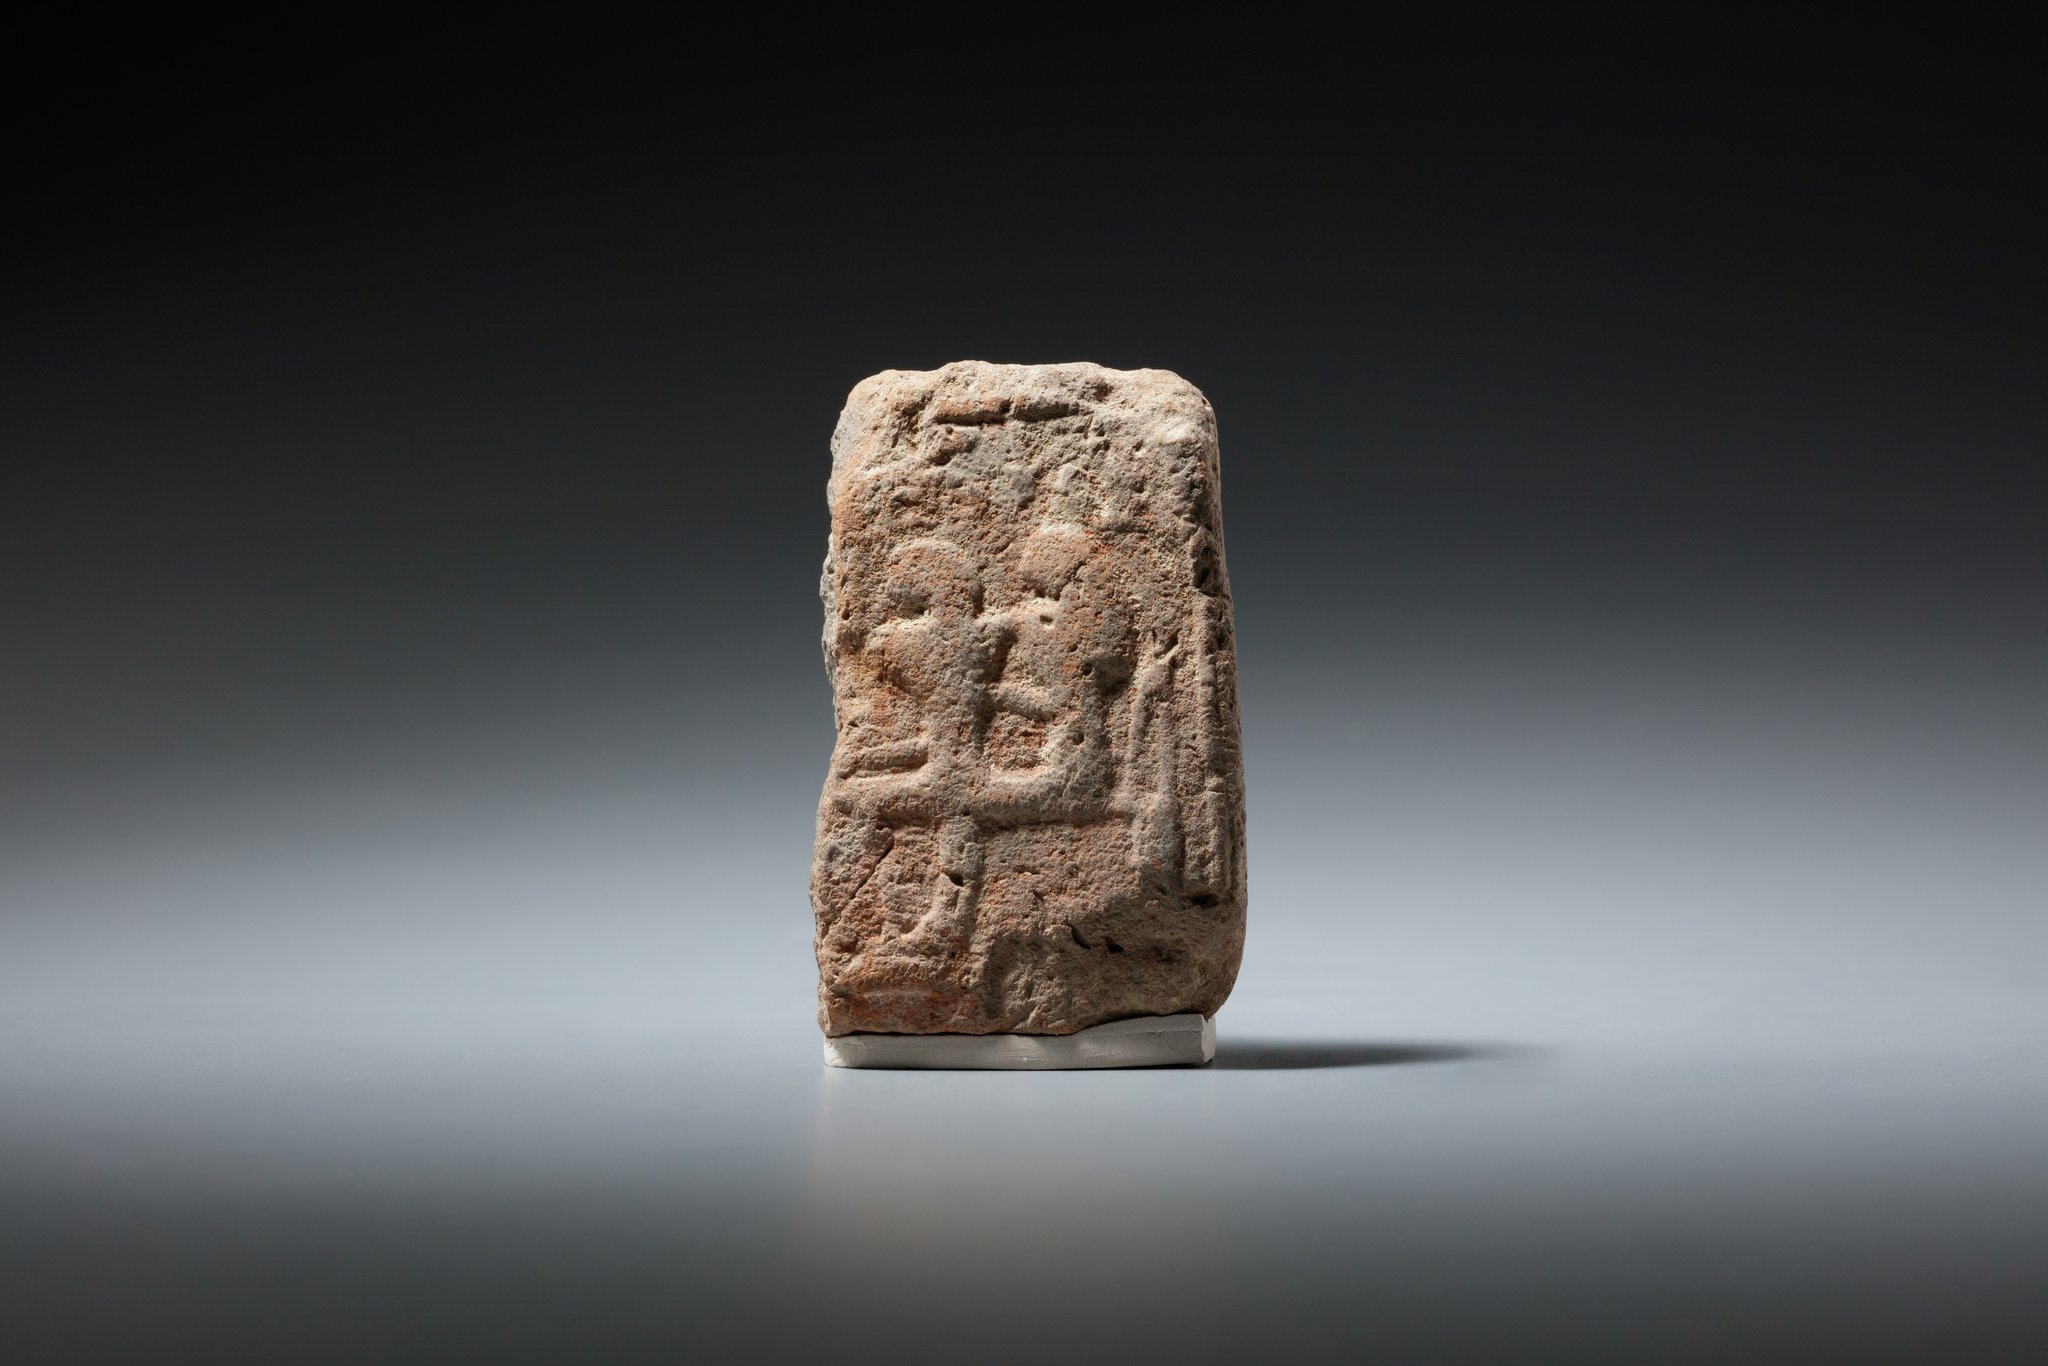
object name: cone, davy 599, aanu, sennu, king's son, house mistress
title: Funerary Cone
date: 1550-1295 BCE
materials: pottery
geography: egypt